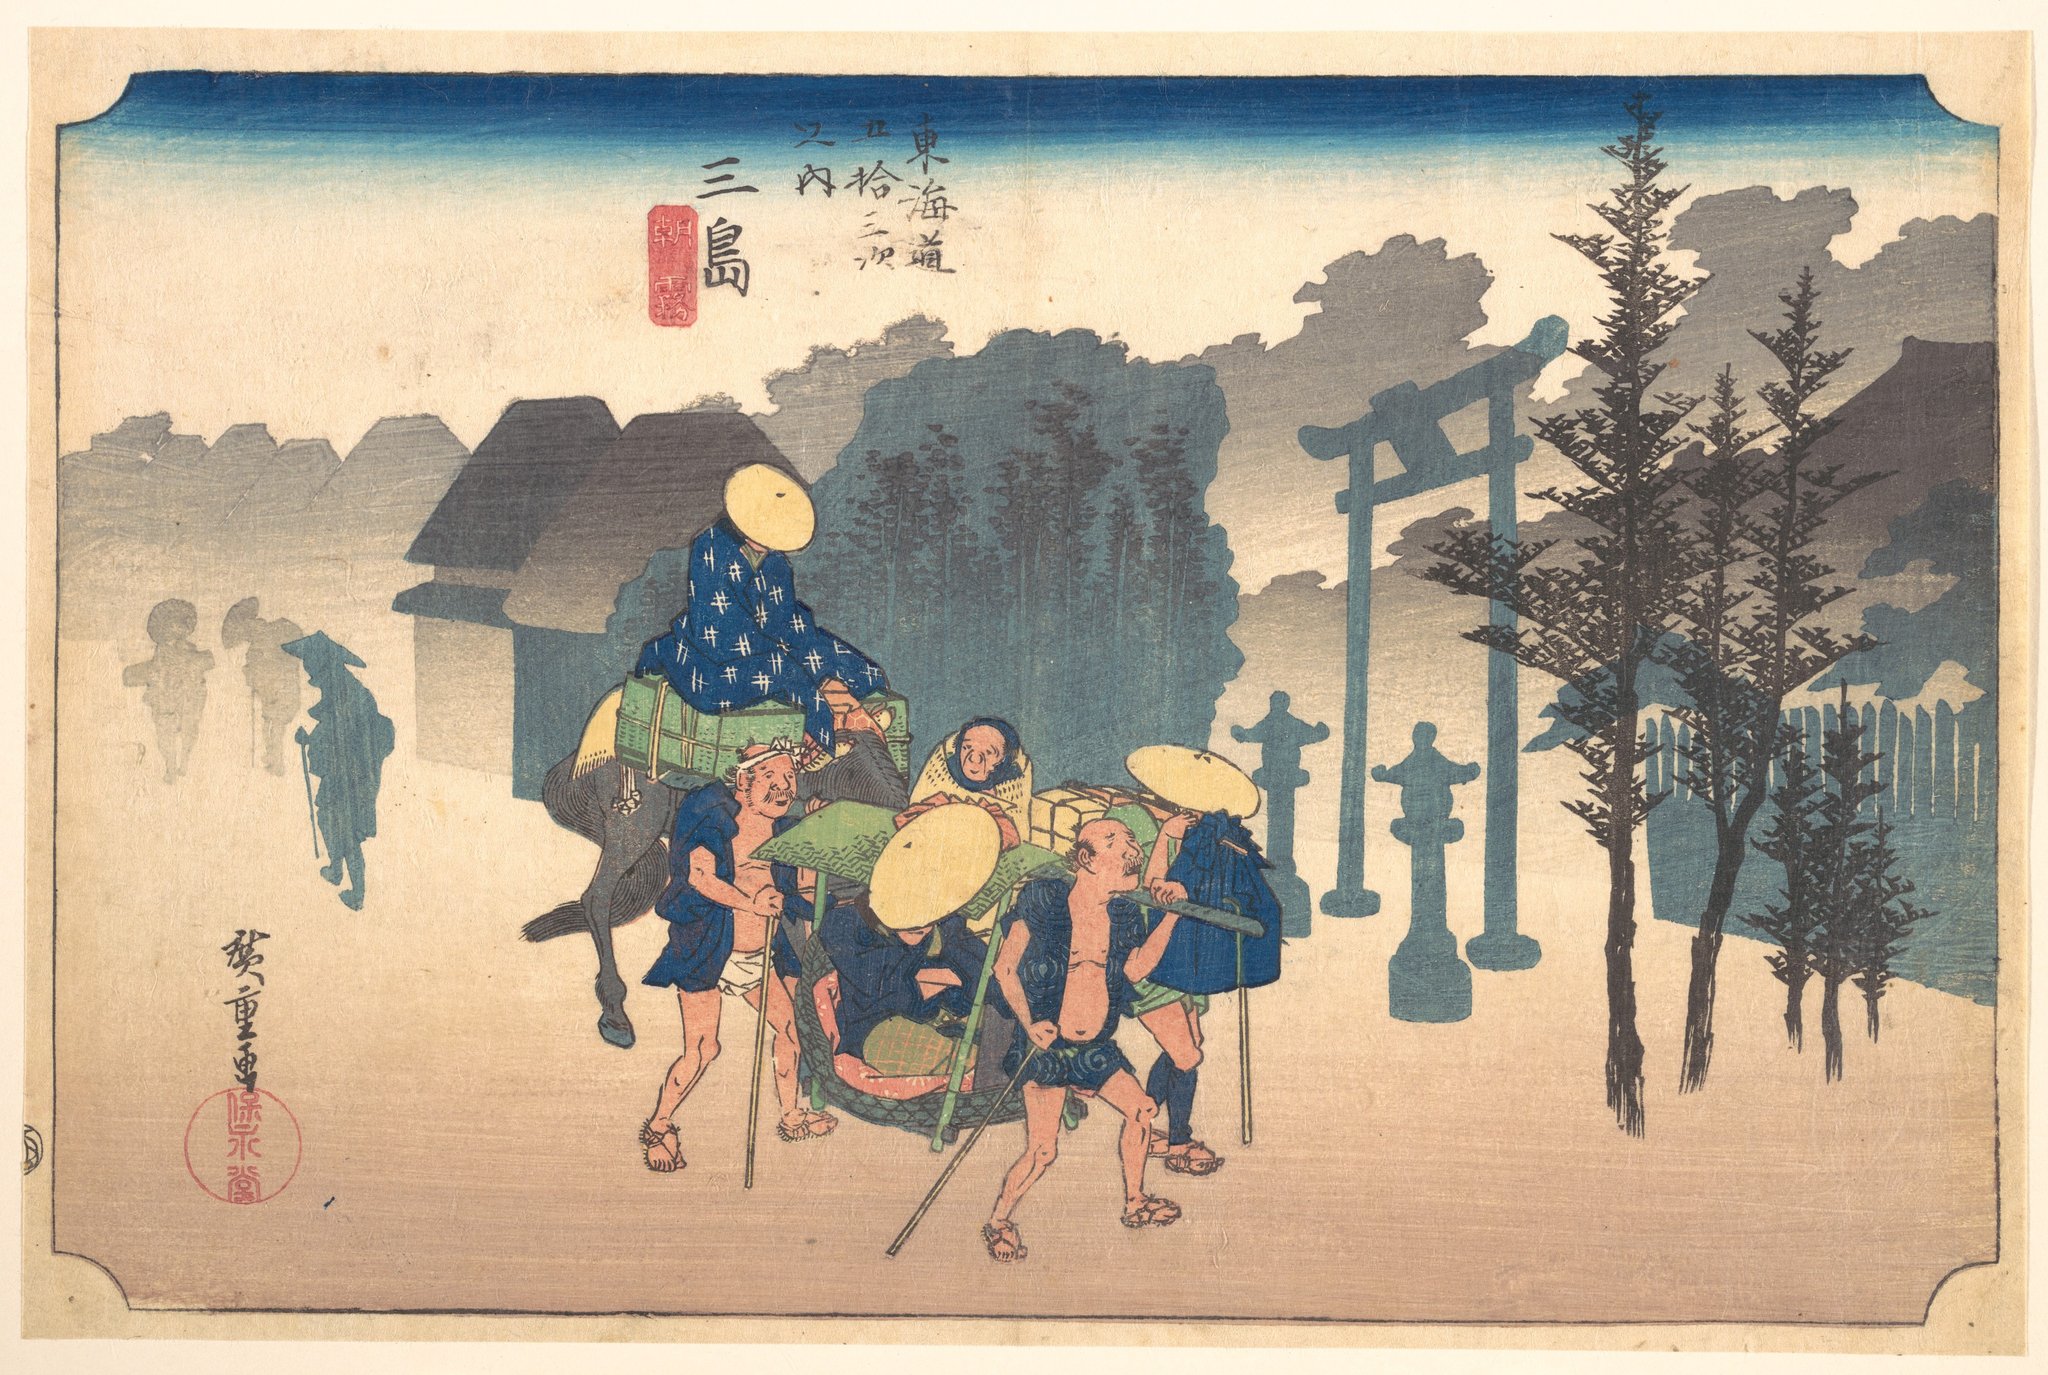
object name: print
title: Morning Mist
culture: japanese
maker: utagawa hiroshige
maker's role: artist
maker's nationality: japanese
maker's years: 1797-1858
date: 1797-1858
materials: ink, paper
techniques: woodblock print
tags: human figures,horses,trees